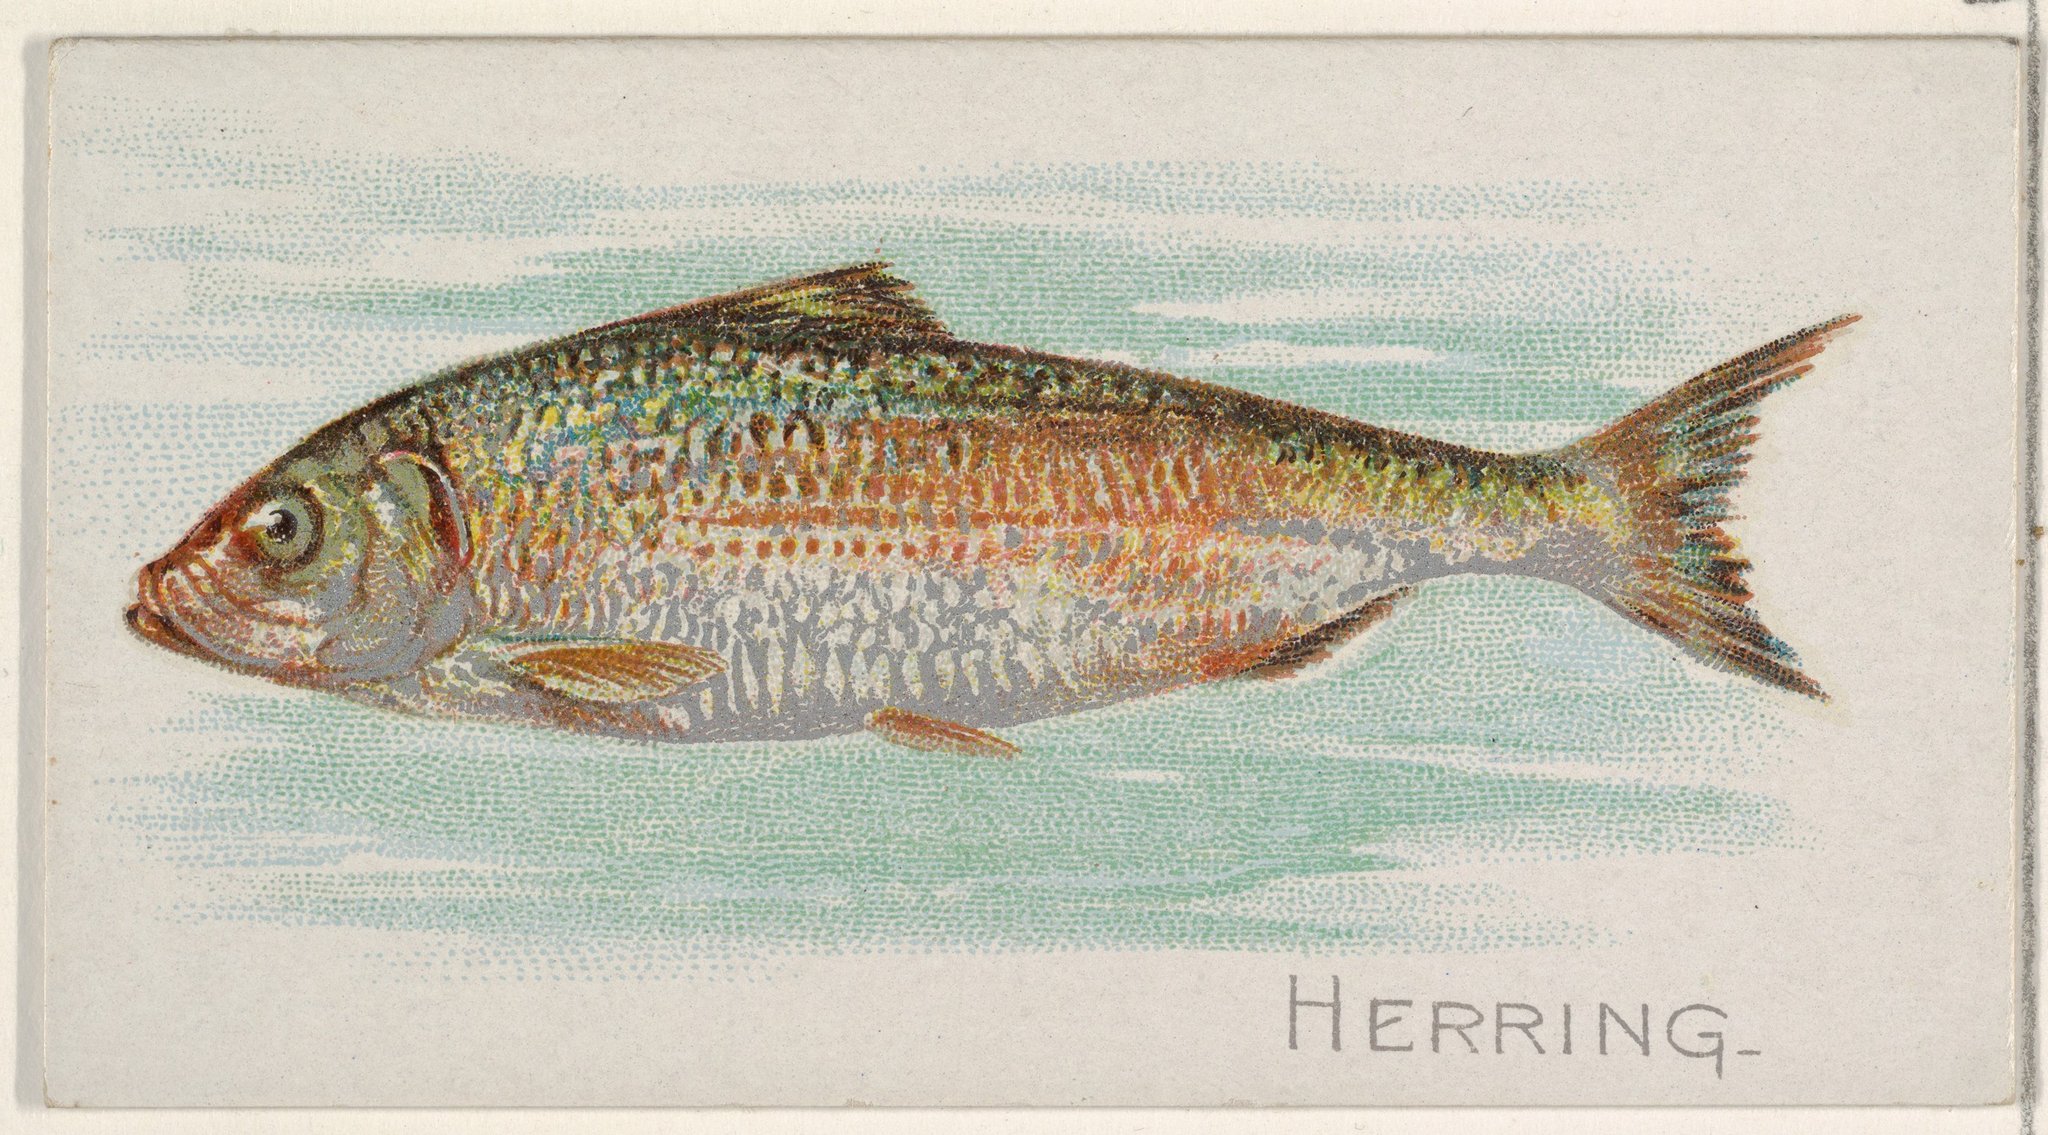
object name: print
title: Herring, from the Fish from American Waters series (N8) for Allen & Ginter Cigarettes Brands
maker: allen & ginter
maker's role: publisher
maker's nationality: american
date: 1889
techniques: color lithograph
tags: fish